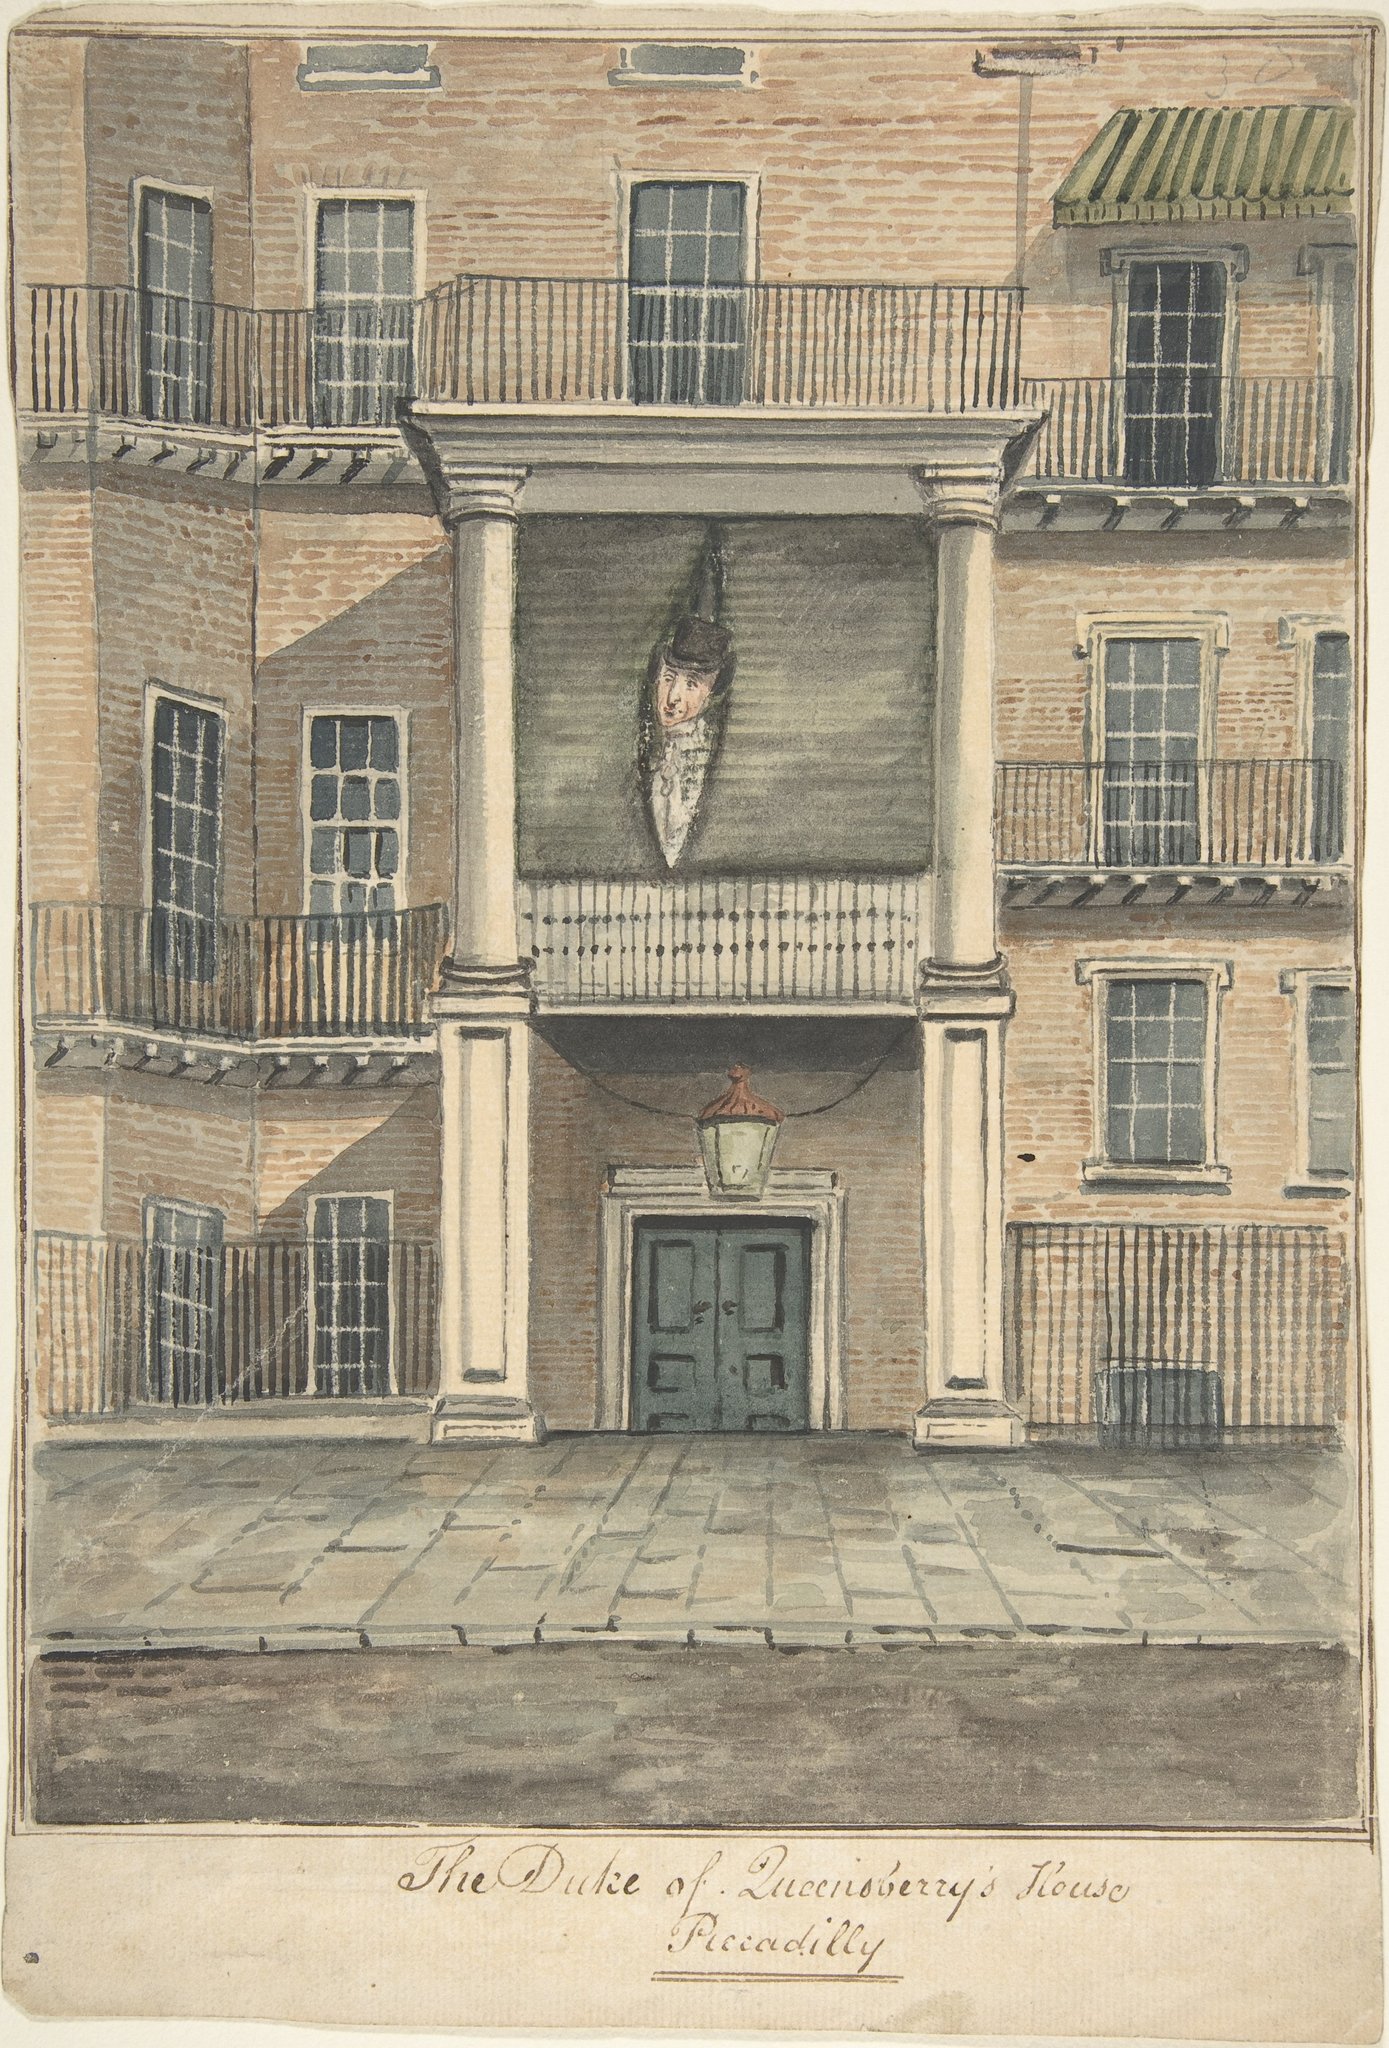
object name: drawing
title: The Duke of Queensbury's House, Piccadilly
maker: anonymous, british, 19th century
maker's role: artist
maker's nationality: british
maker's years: 1800-1900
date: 1801-1900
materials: ink, watercolor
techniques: pen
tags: houses